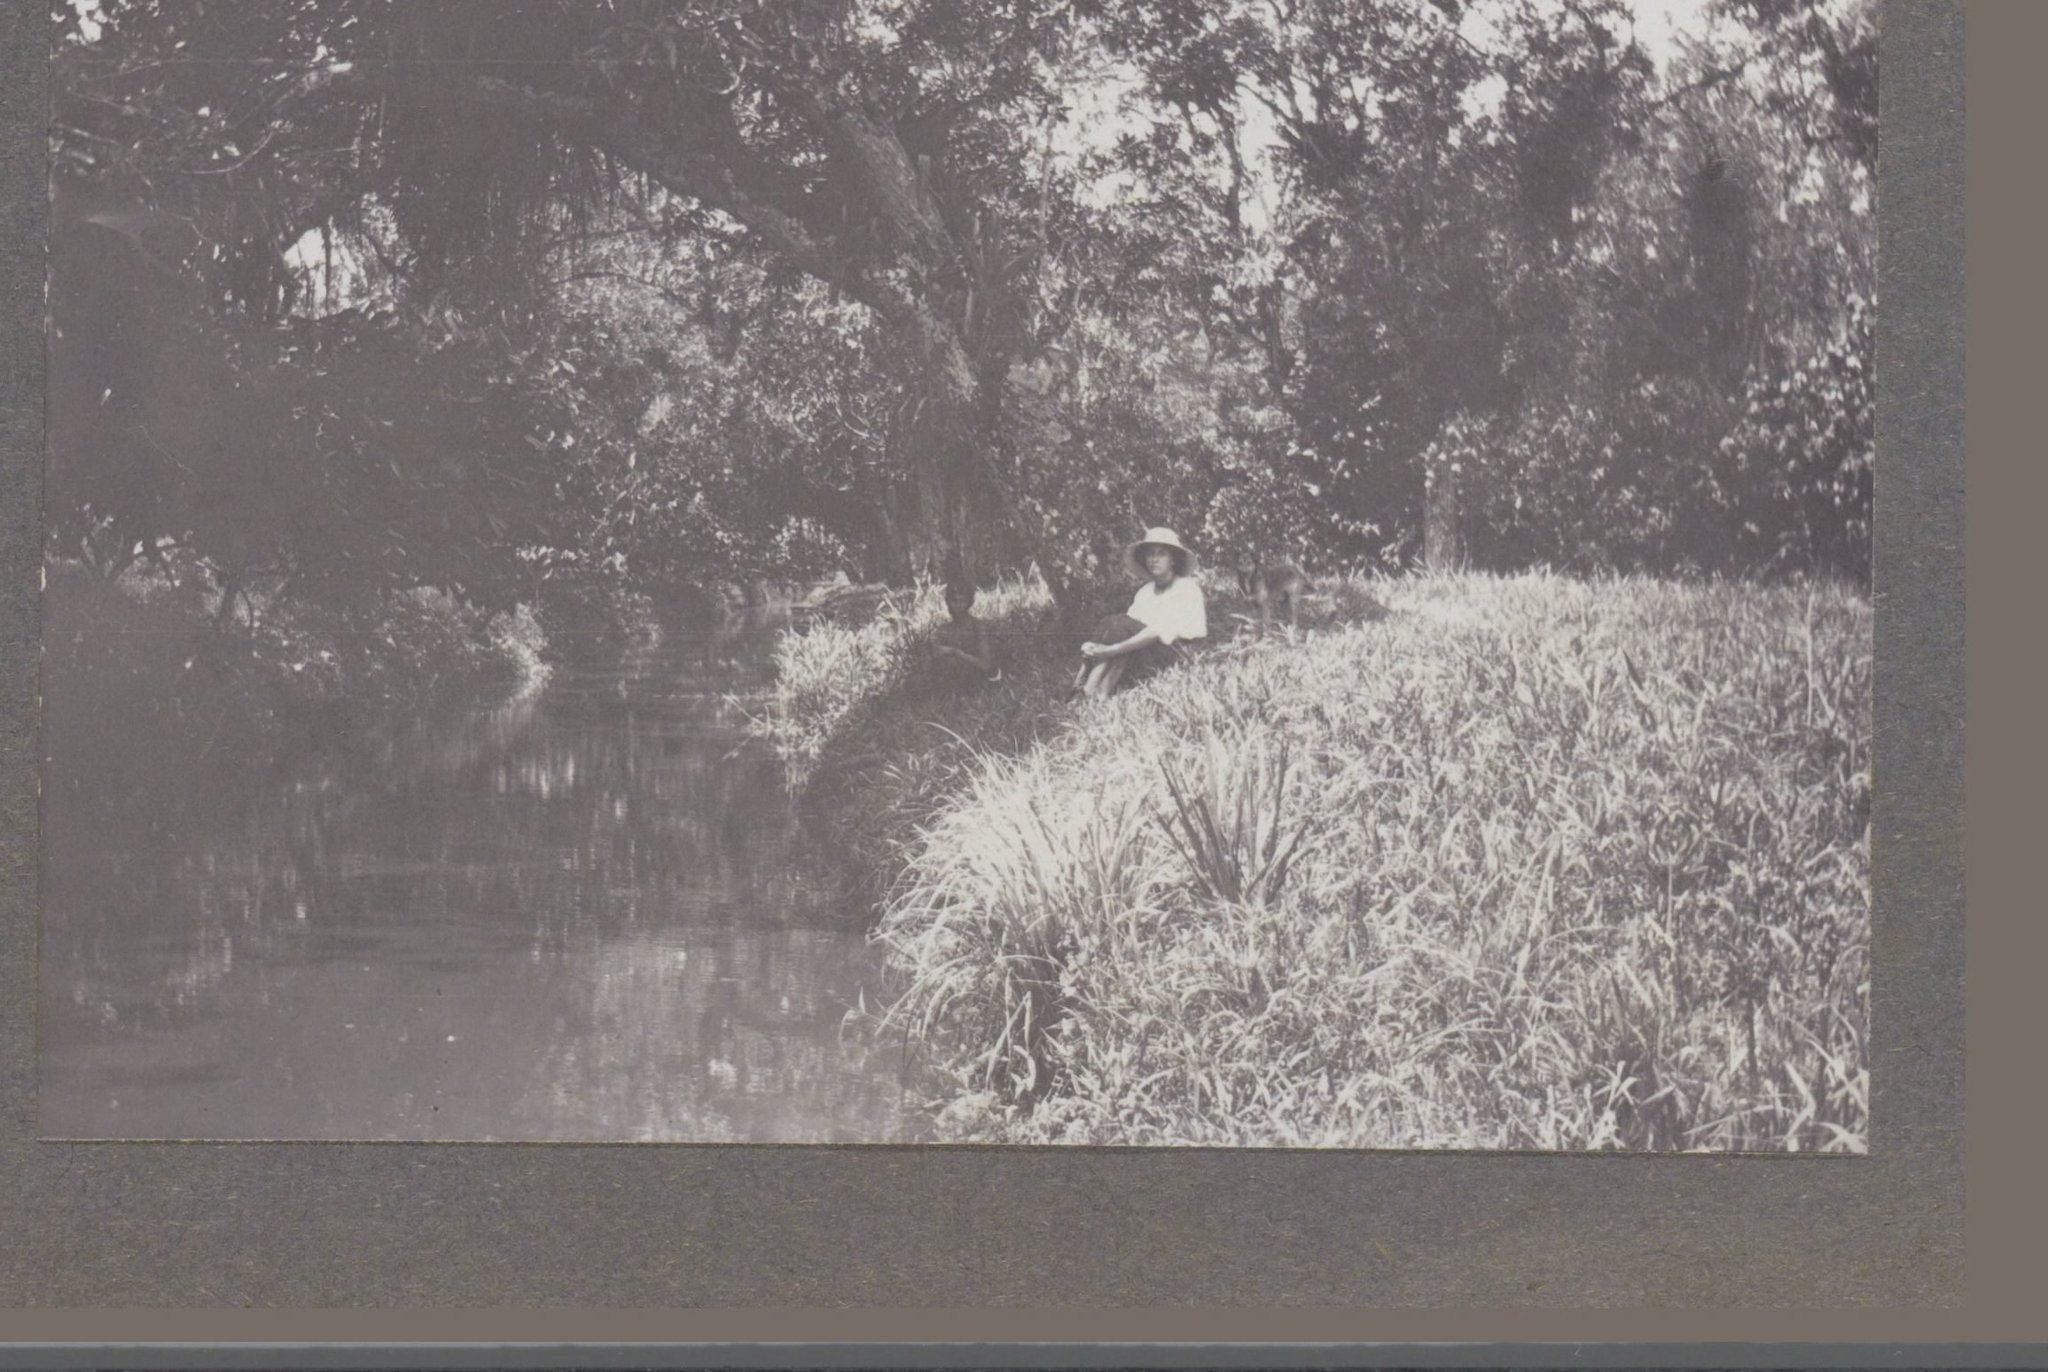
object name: photograph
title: Maria Gonggrijp, zittend aan de waterkant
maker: Anonymous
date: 1912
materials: photographic support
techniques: photography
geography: suriname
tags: plantation, suriname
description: Maria Gonggrijp zittend aan de waterkant, met een grote zonnehoed op het hoofd. Achter haar een hond, op Plantage Clevia. Onderdeel van het fotoalbum over het leven van de familie Gonggrijp in Suriname rond 1912.